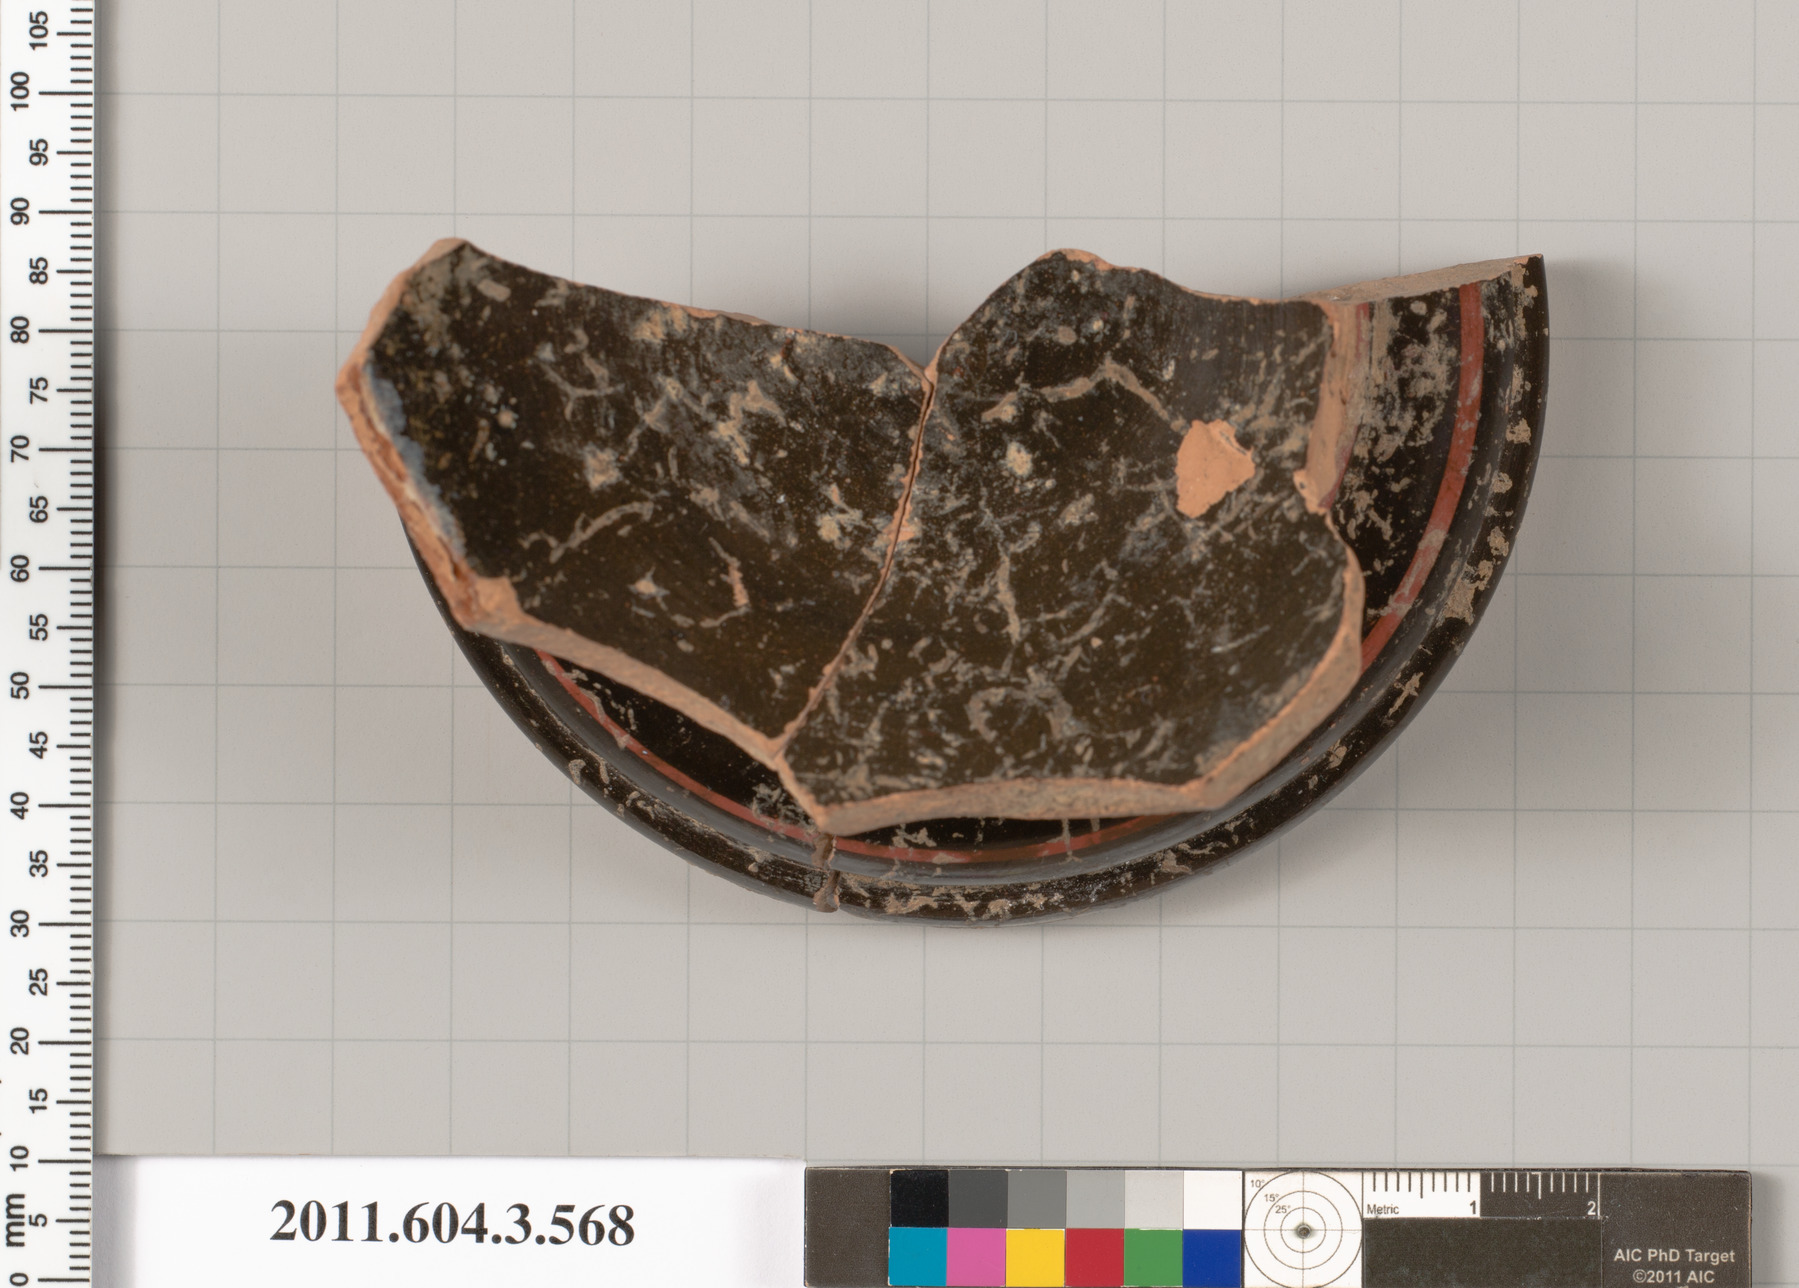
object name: column krater fragment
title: Terracotta fragment of a column-krater (bowl for mixing wine and water)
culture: greek, attic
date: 534-468 BCE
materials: terracotta